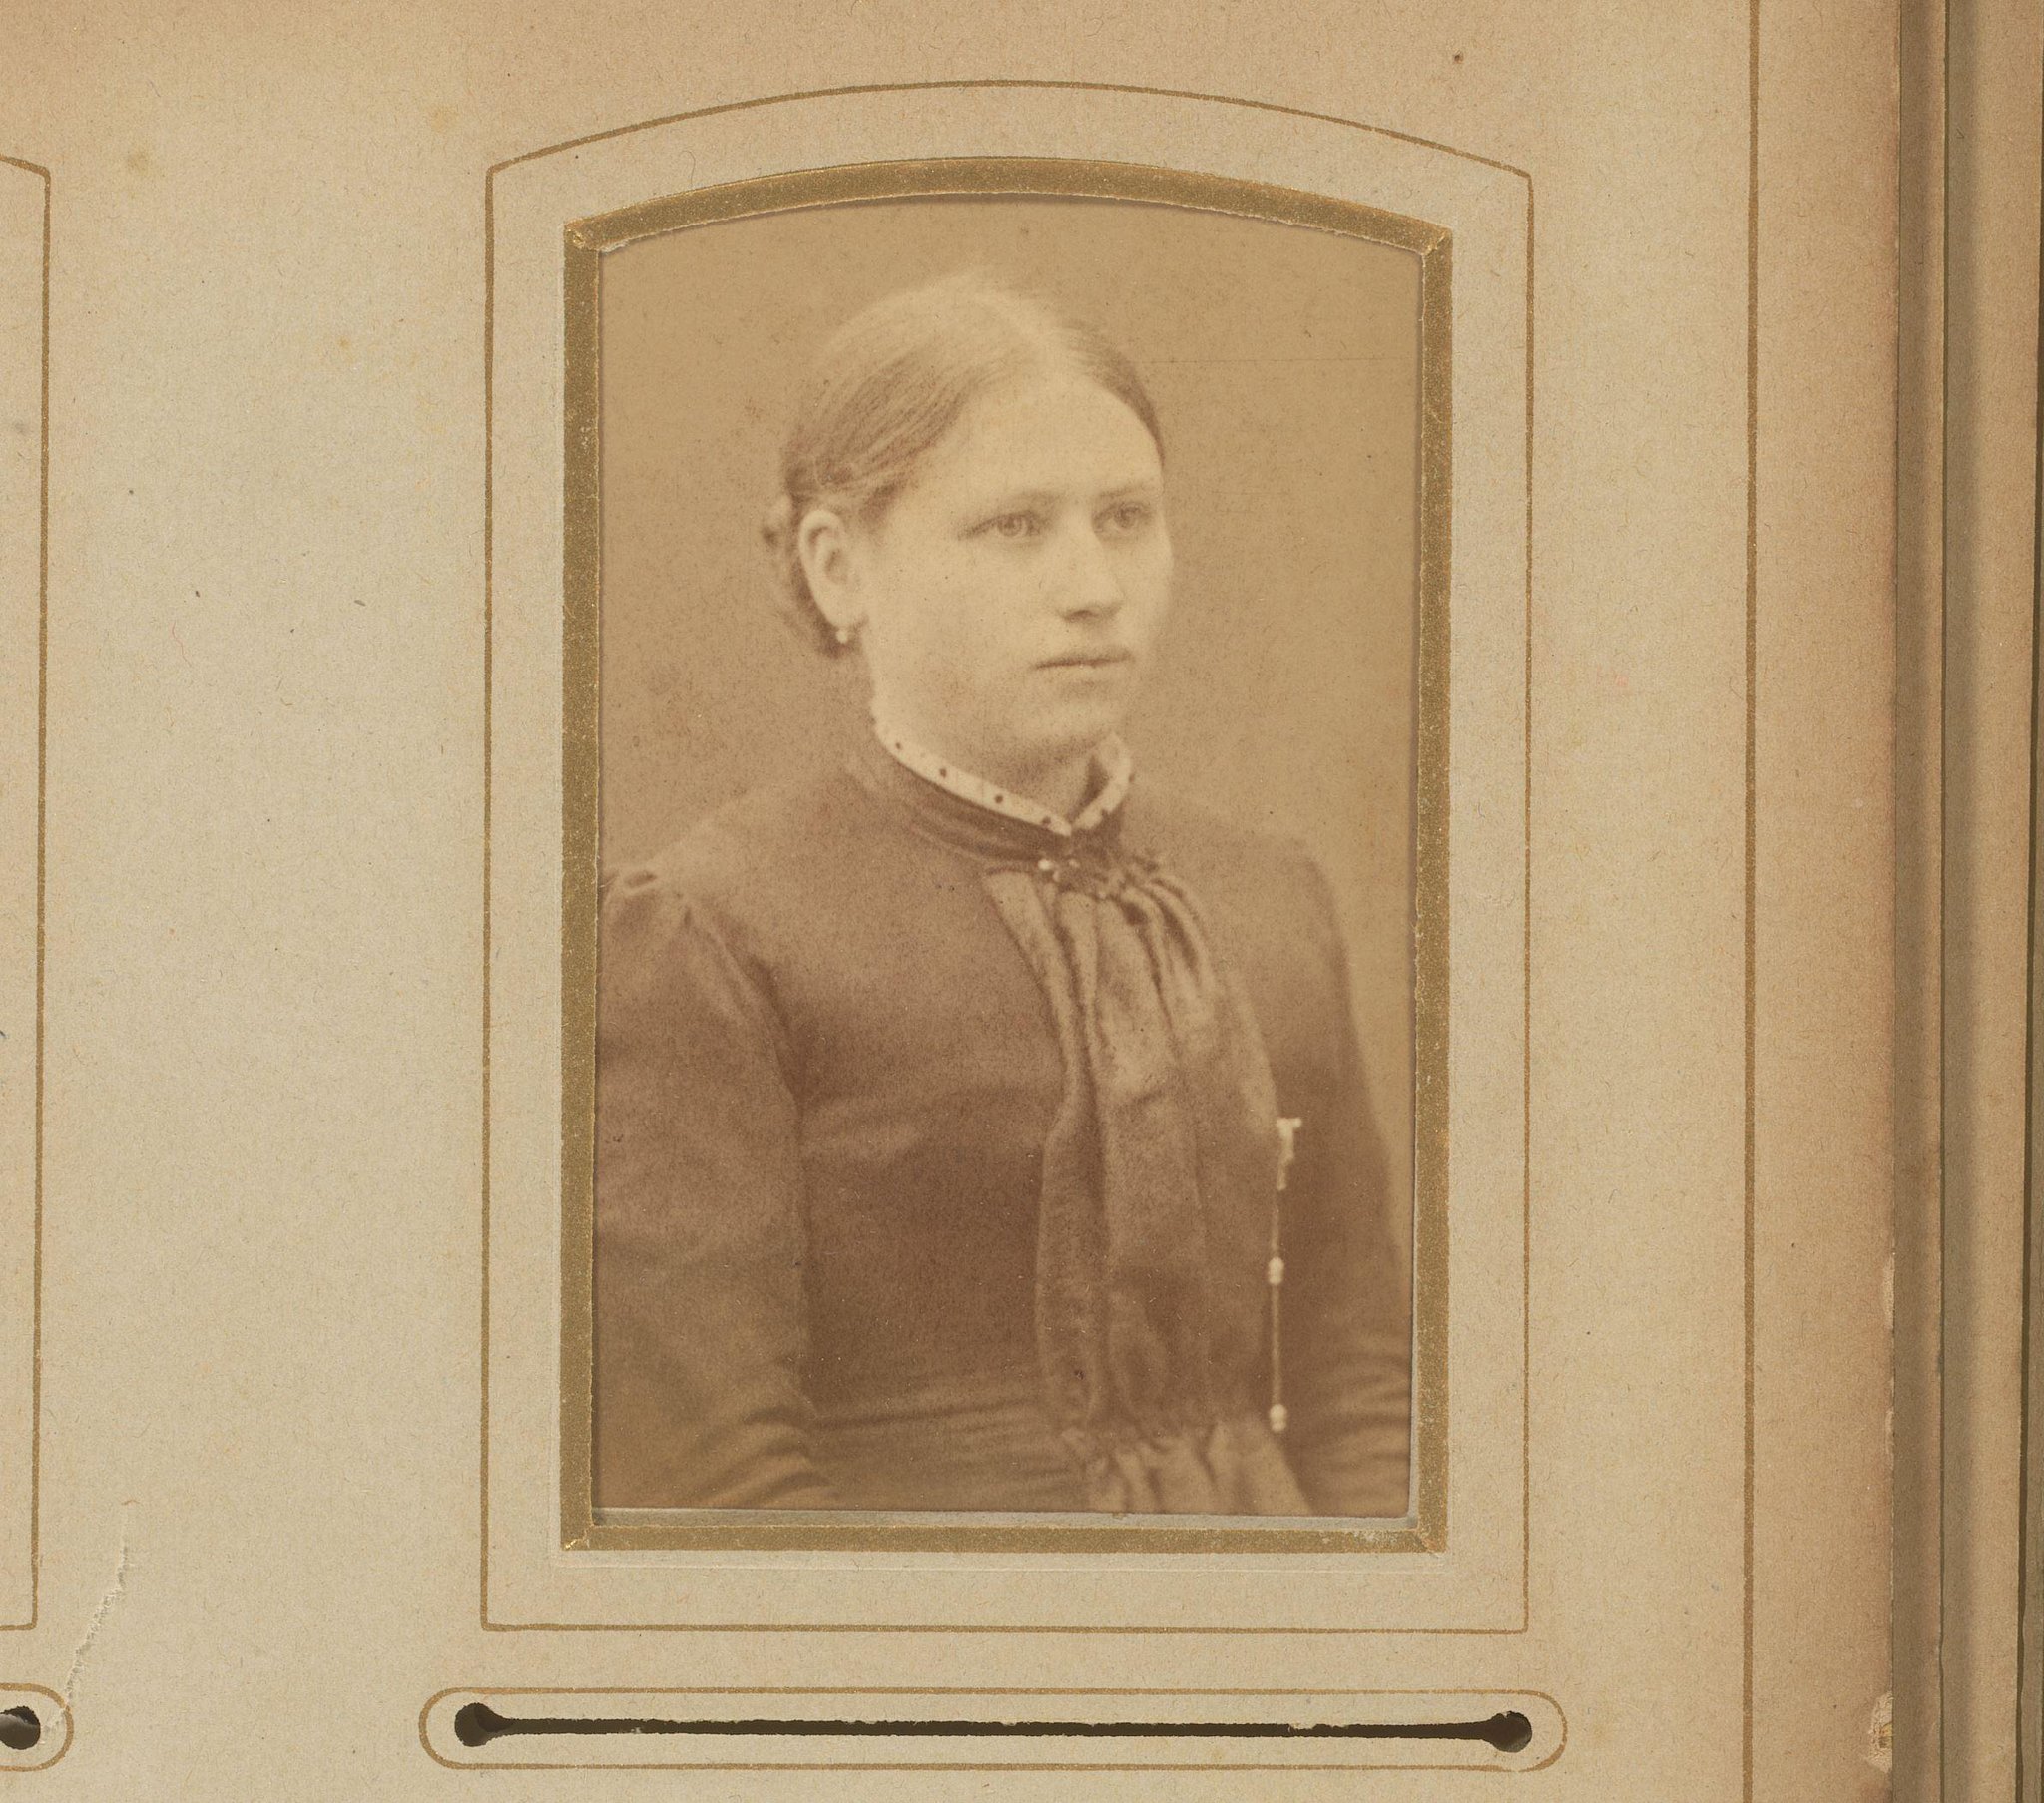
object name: photograph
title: Portret van een jonge vrouw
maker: georges raynaud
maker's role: fotograaf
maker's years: 1847-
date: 1880-1900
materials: cardboard, photographic support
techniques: albumen print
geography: antwerp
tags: adolescent, young woman, maiden, historical persons - bb - woman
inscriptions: inscription: ‘G. Raynaud/ 23, Rempart St. Catherine/ Anvers’